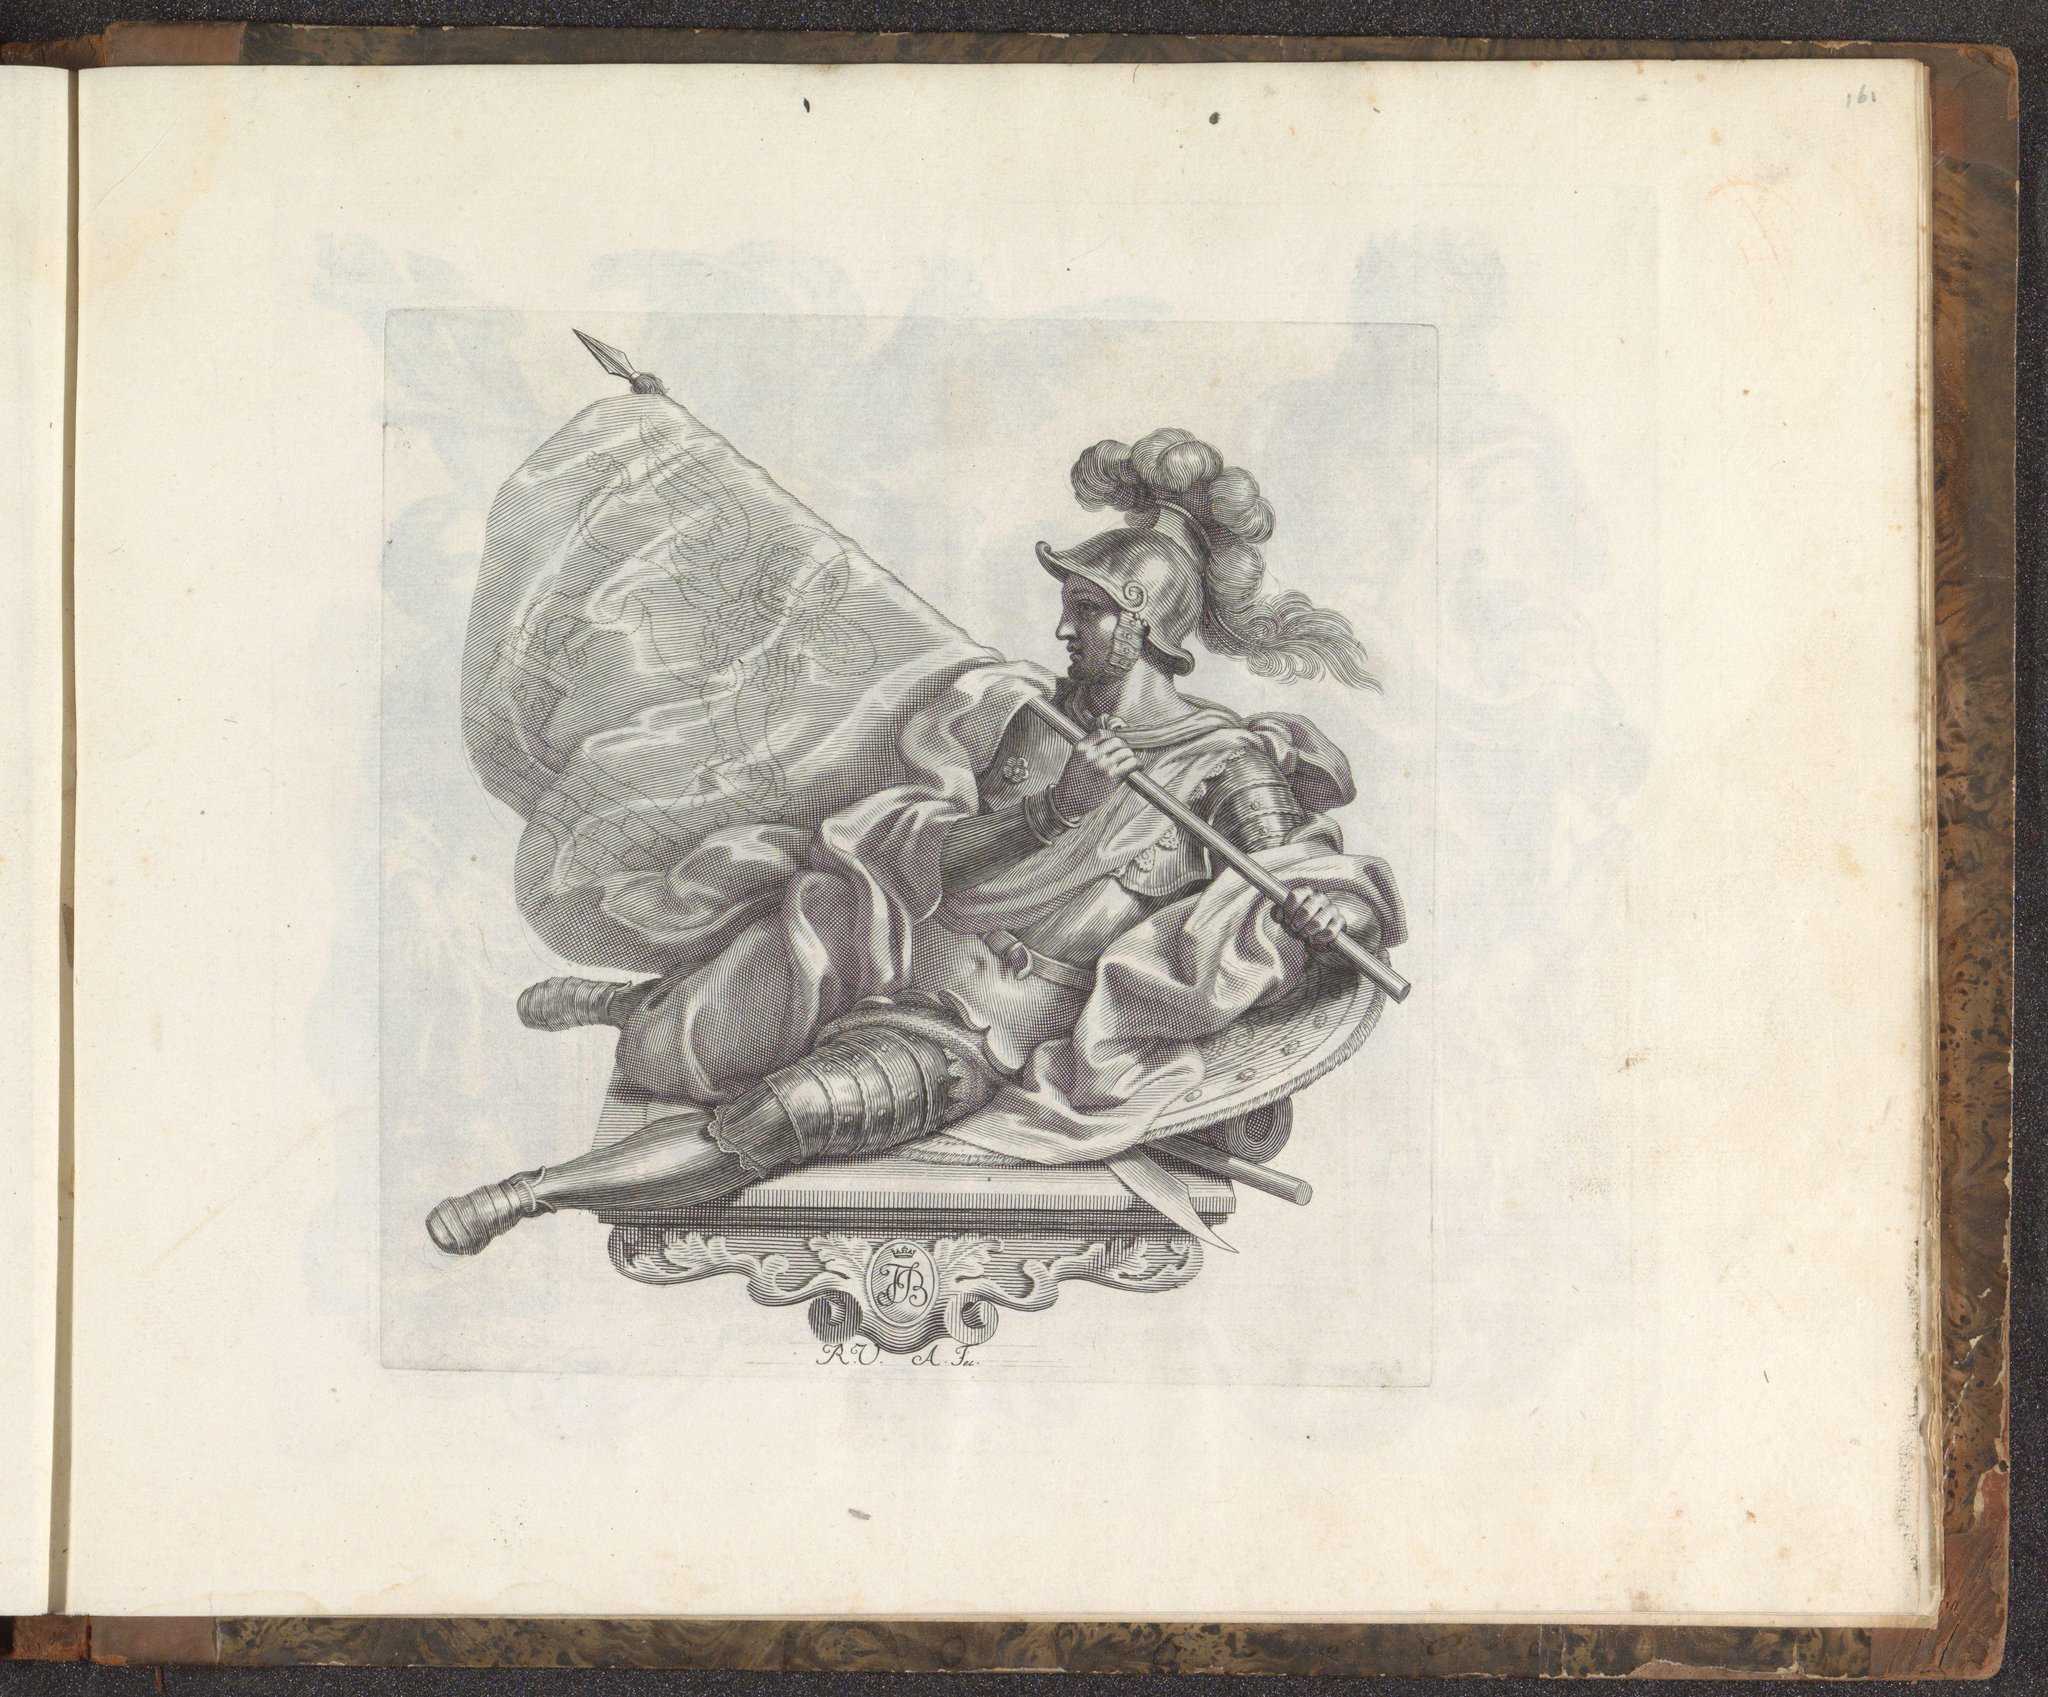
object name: print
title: Soldaat met het vaandel van Venetië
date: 1673-1743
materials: paper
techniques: engraving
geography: rome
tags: lion (possibly with book) ~ symbol of st. mark, the soldier; the soldier's life, venice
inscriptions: collector's mark: Lugt 2228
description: Een console met een soldaat liggende op zijn schild en in zijn handen een vaandel met het wapen van Venetië: een gevleugelde leeuw. De prent maakt deel uit van een album.